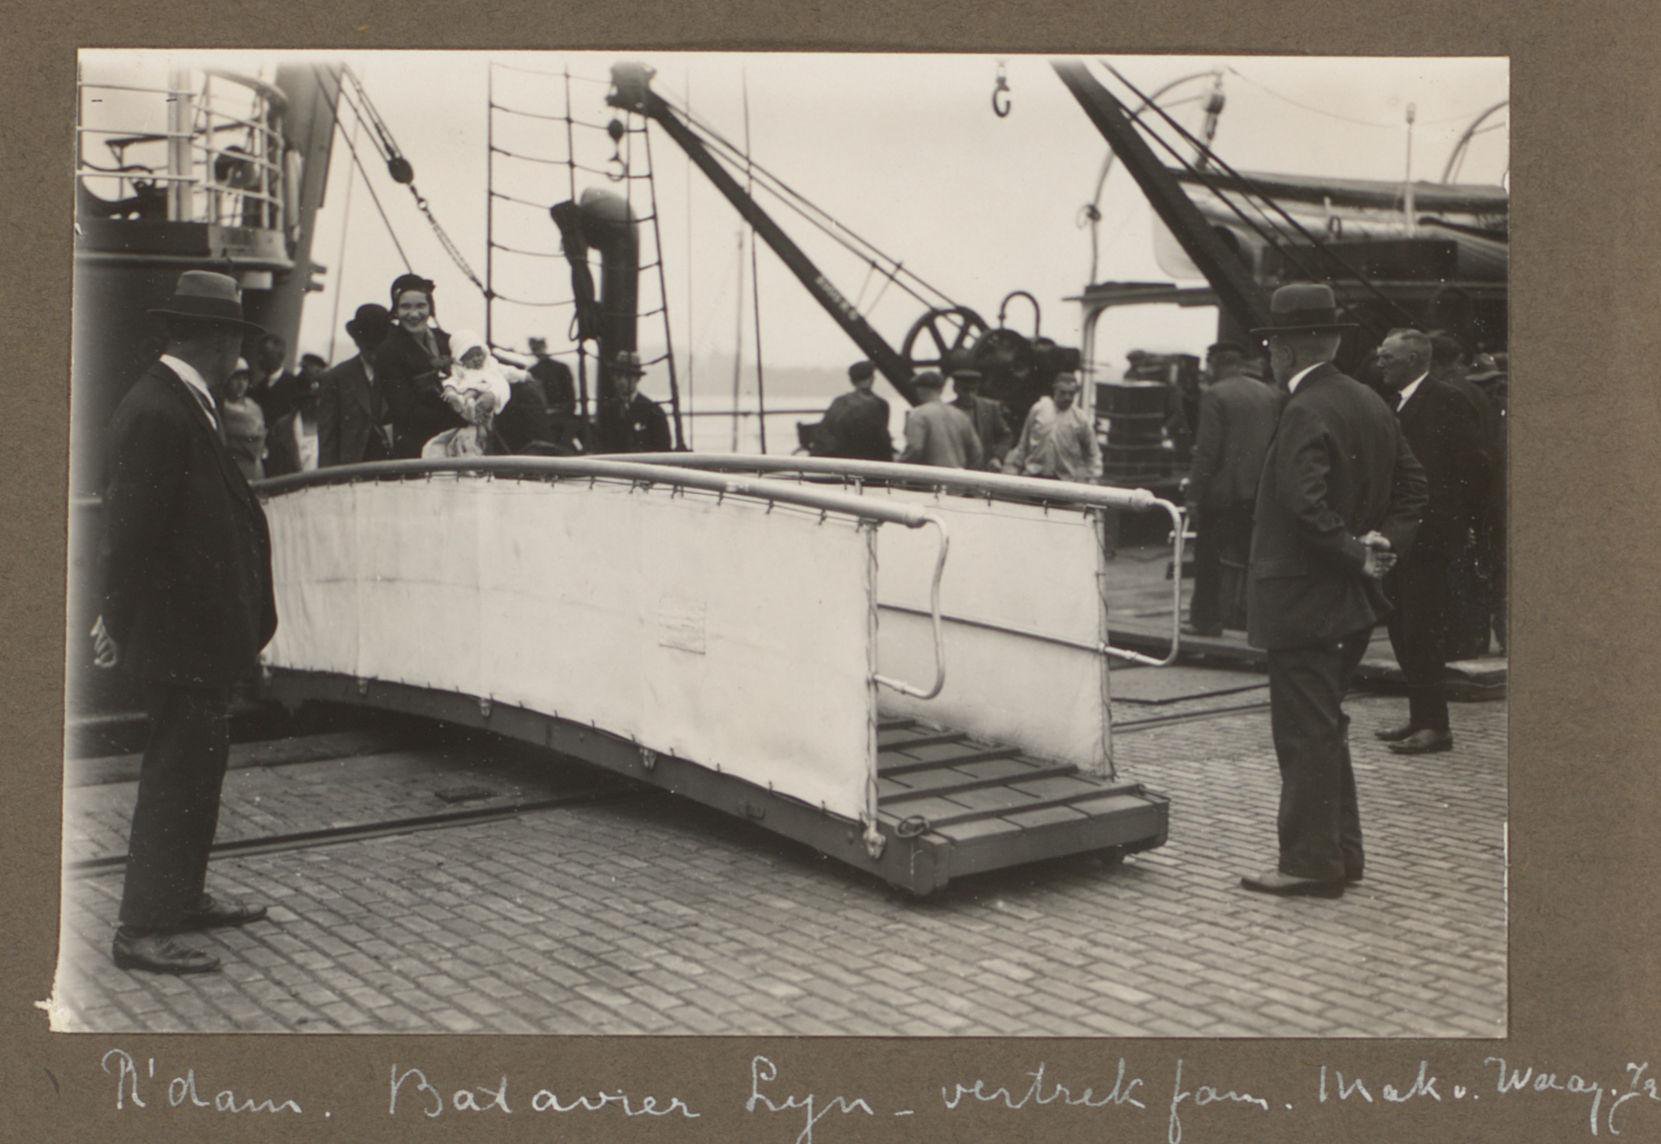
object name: photograph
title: Wisseling van de wacht voor Buckingham Palace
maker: Anonymous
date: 1906-1932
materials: paper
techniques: gelatin silver print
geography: london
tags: changing the guard